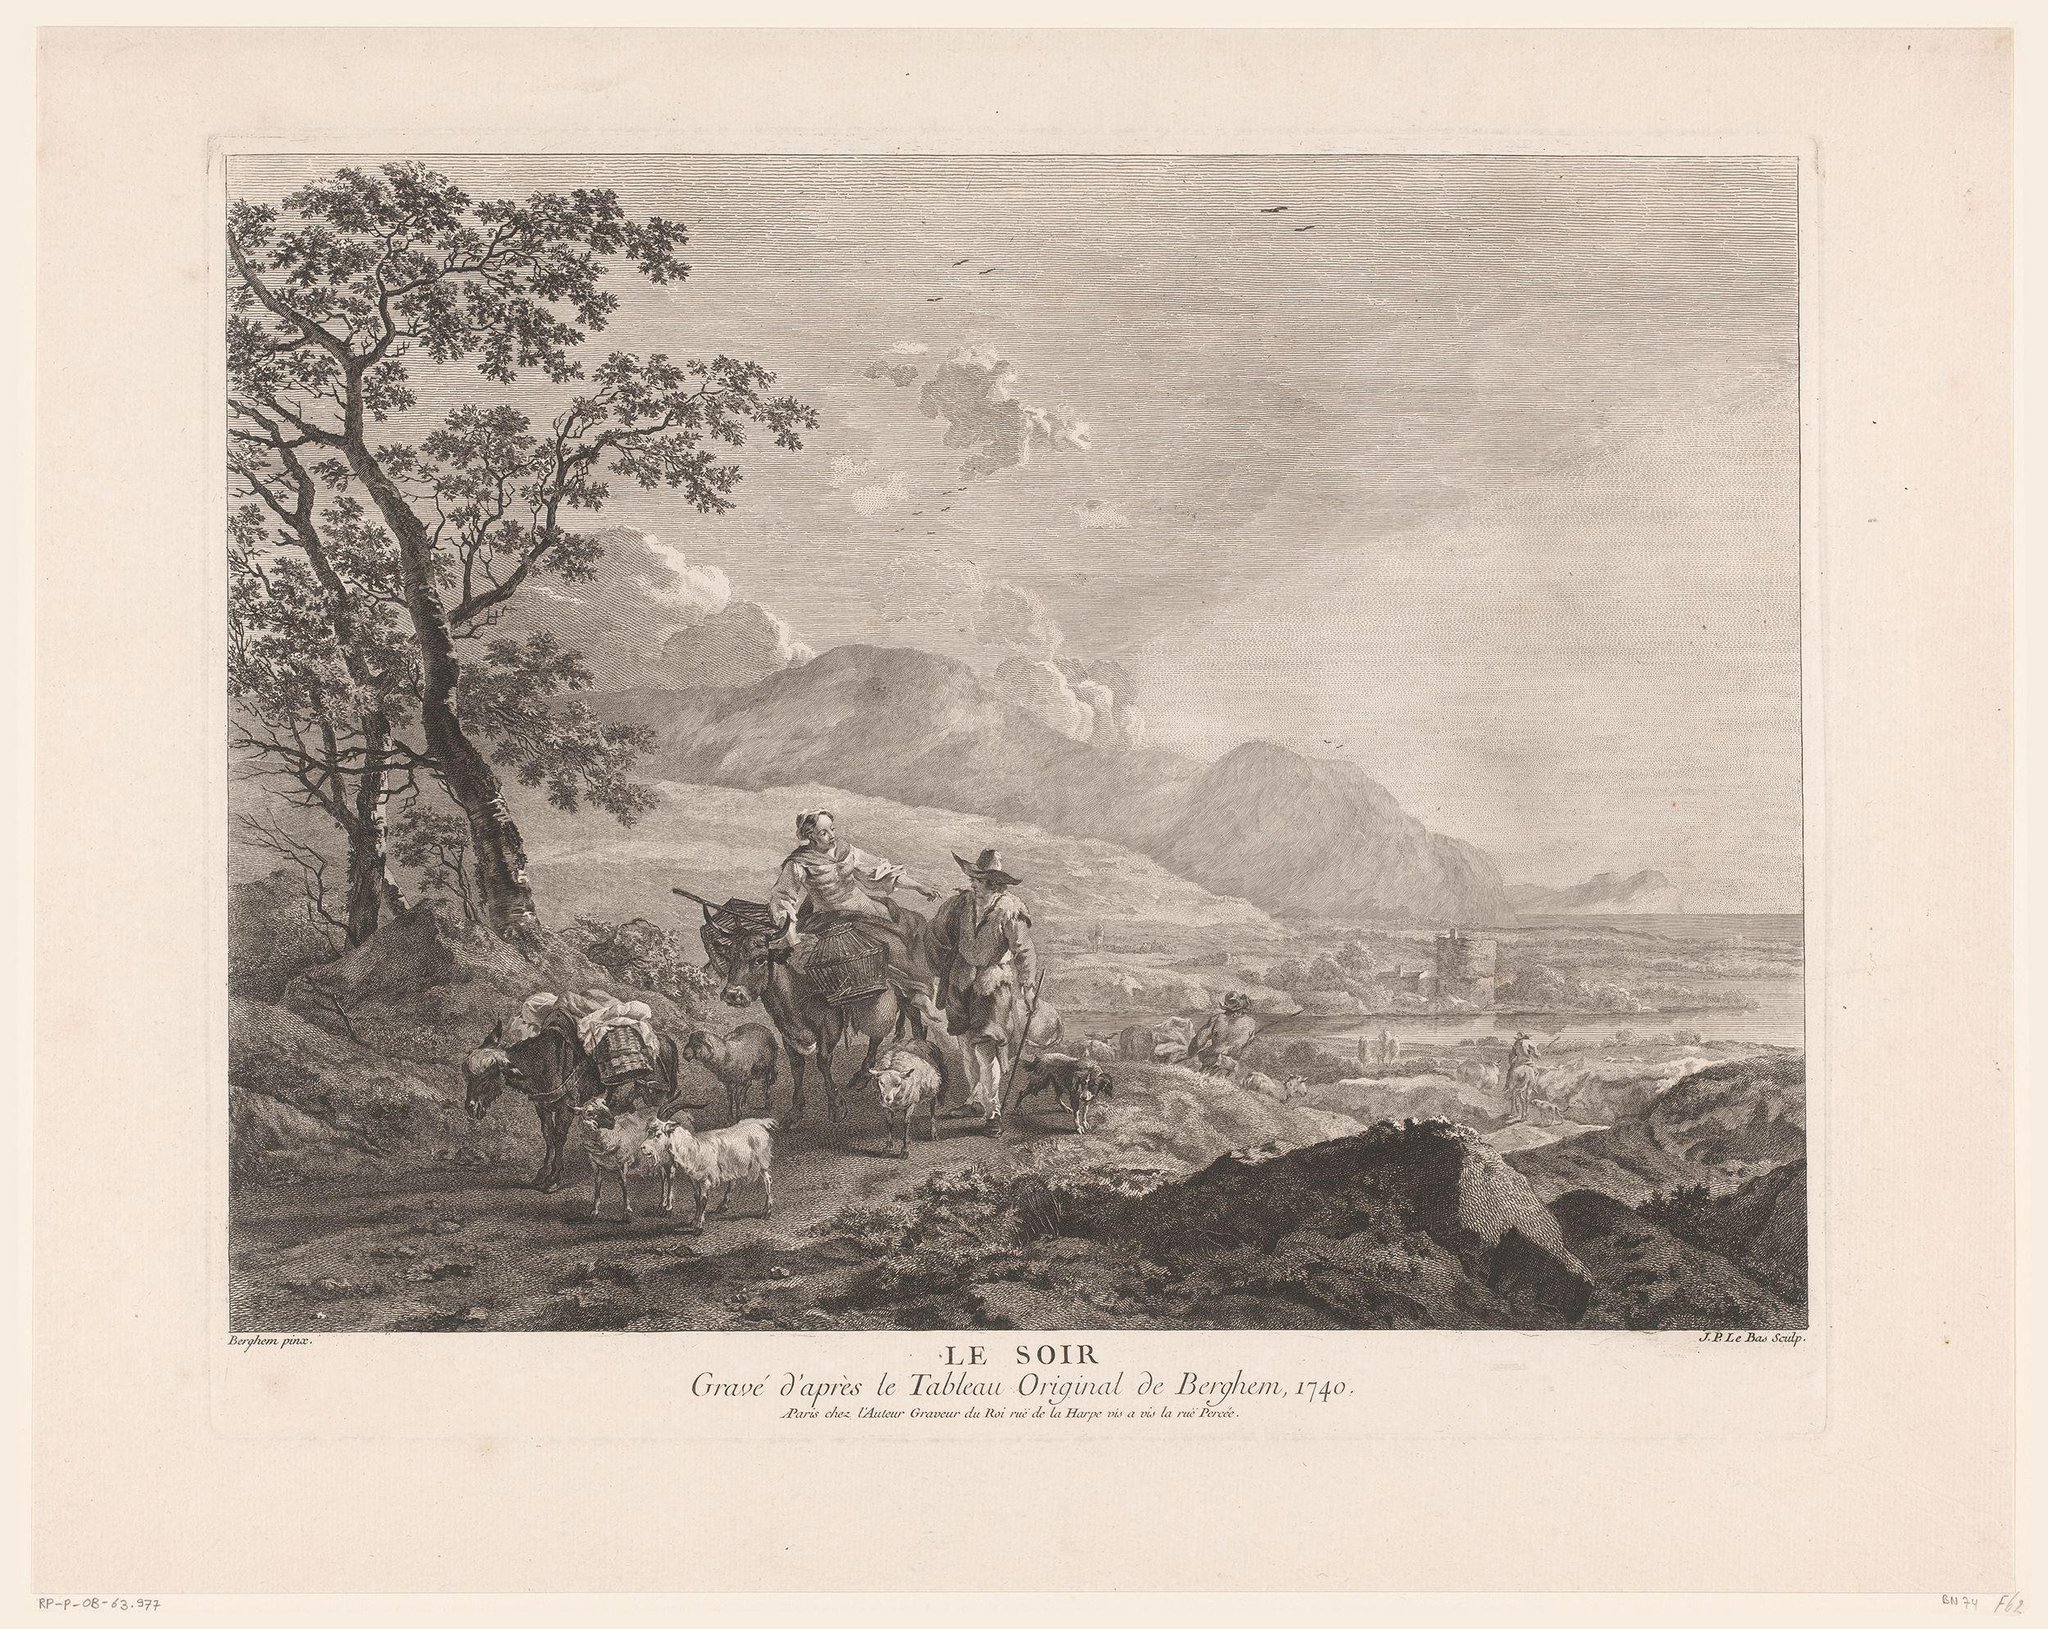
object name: print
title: Kustlandschap met herders op een pad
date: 1740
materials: paper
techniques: engraving, etching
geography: paris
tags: herding, herdsman, herdswoman, shepherd, shepherdess, cowherd, etc., landscapes (+ landscape with figures, staffage), herd, flock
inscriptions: collector's mark: Lugt 240